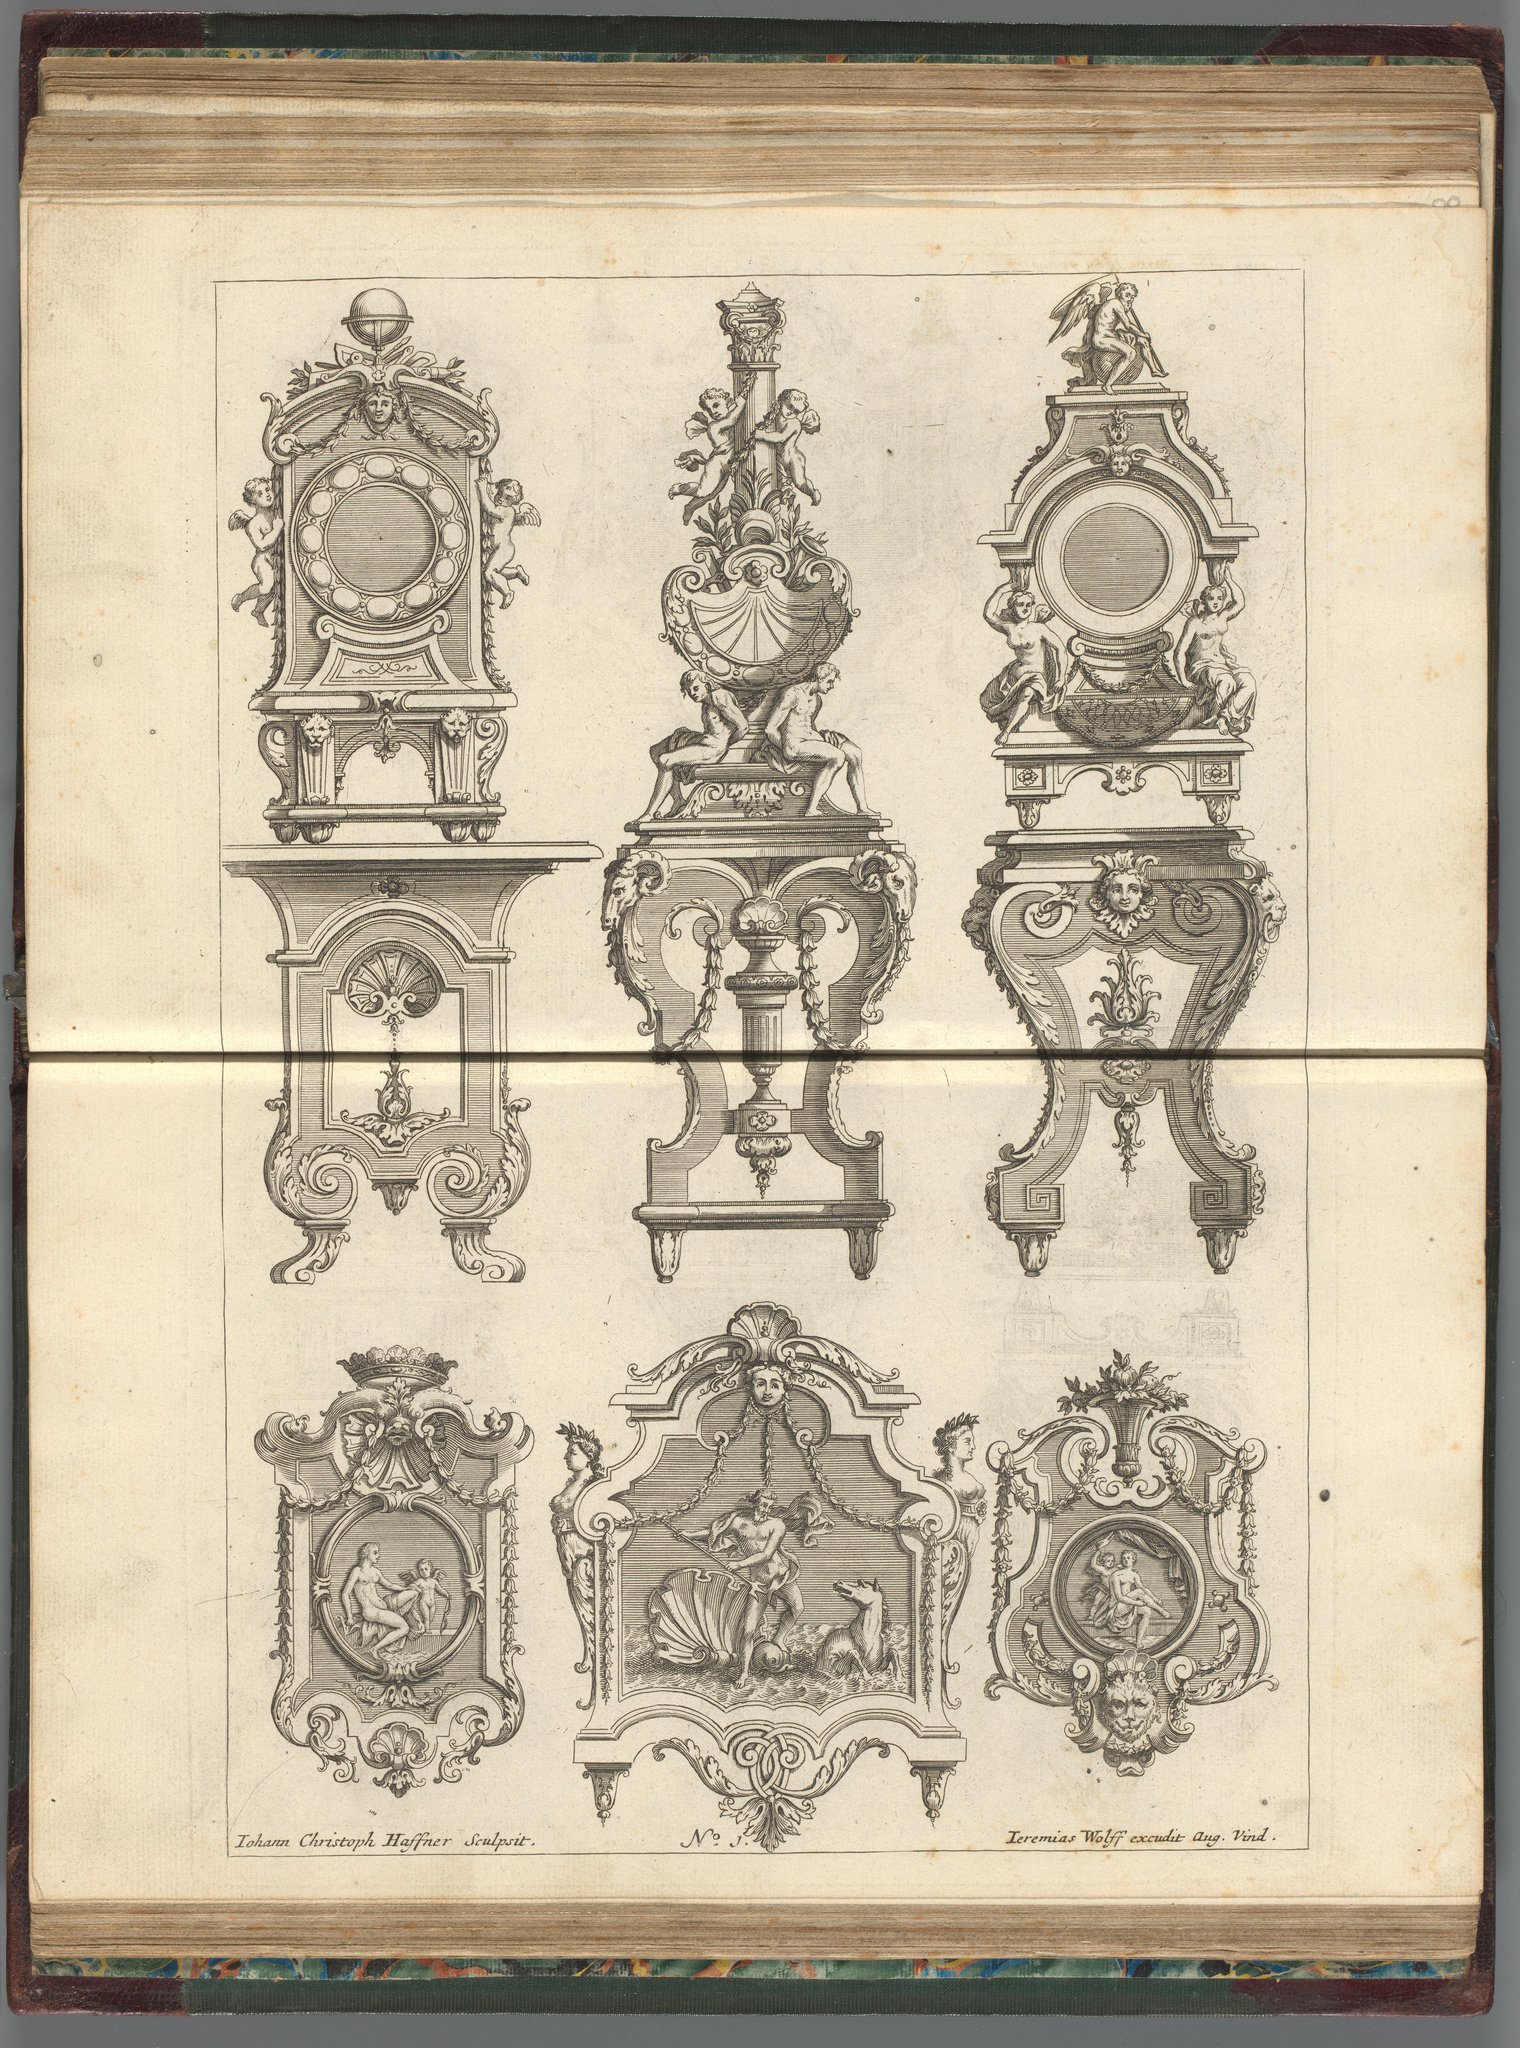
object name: album leaf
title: Ontwerpen van klokken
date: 1686-1724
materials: paper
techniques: etching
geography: augsburg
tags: (story of) neptune (poseidon), ornaments ~ art, clock, ornament ~ cartouche, venus and cupid (cupid not being mere attribute)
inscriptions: signature: ‘Iohann Christoph Haffner Sculpsit’, signature: ‘Ieremias Wolff excudit Aug. Vind.’, number: ‘No. 1.’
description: Drie ontwerpen van klokken met daaronder drie cartouches met Neptunus en Venus en Amor. Prent maakt deel uit van een album. Hoogstwaarschijnlijk gespiegelde kopie naar Frans origineel.